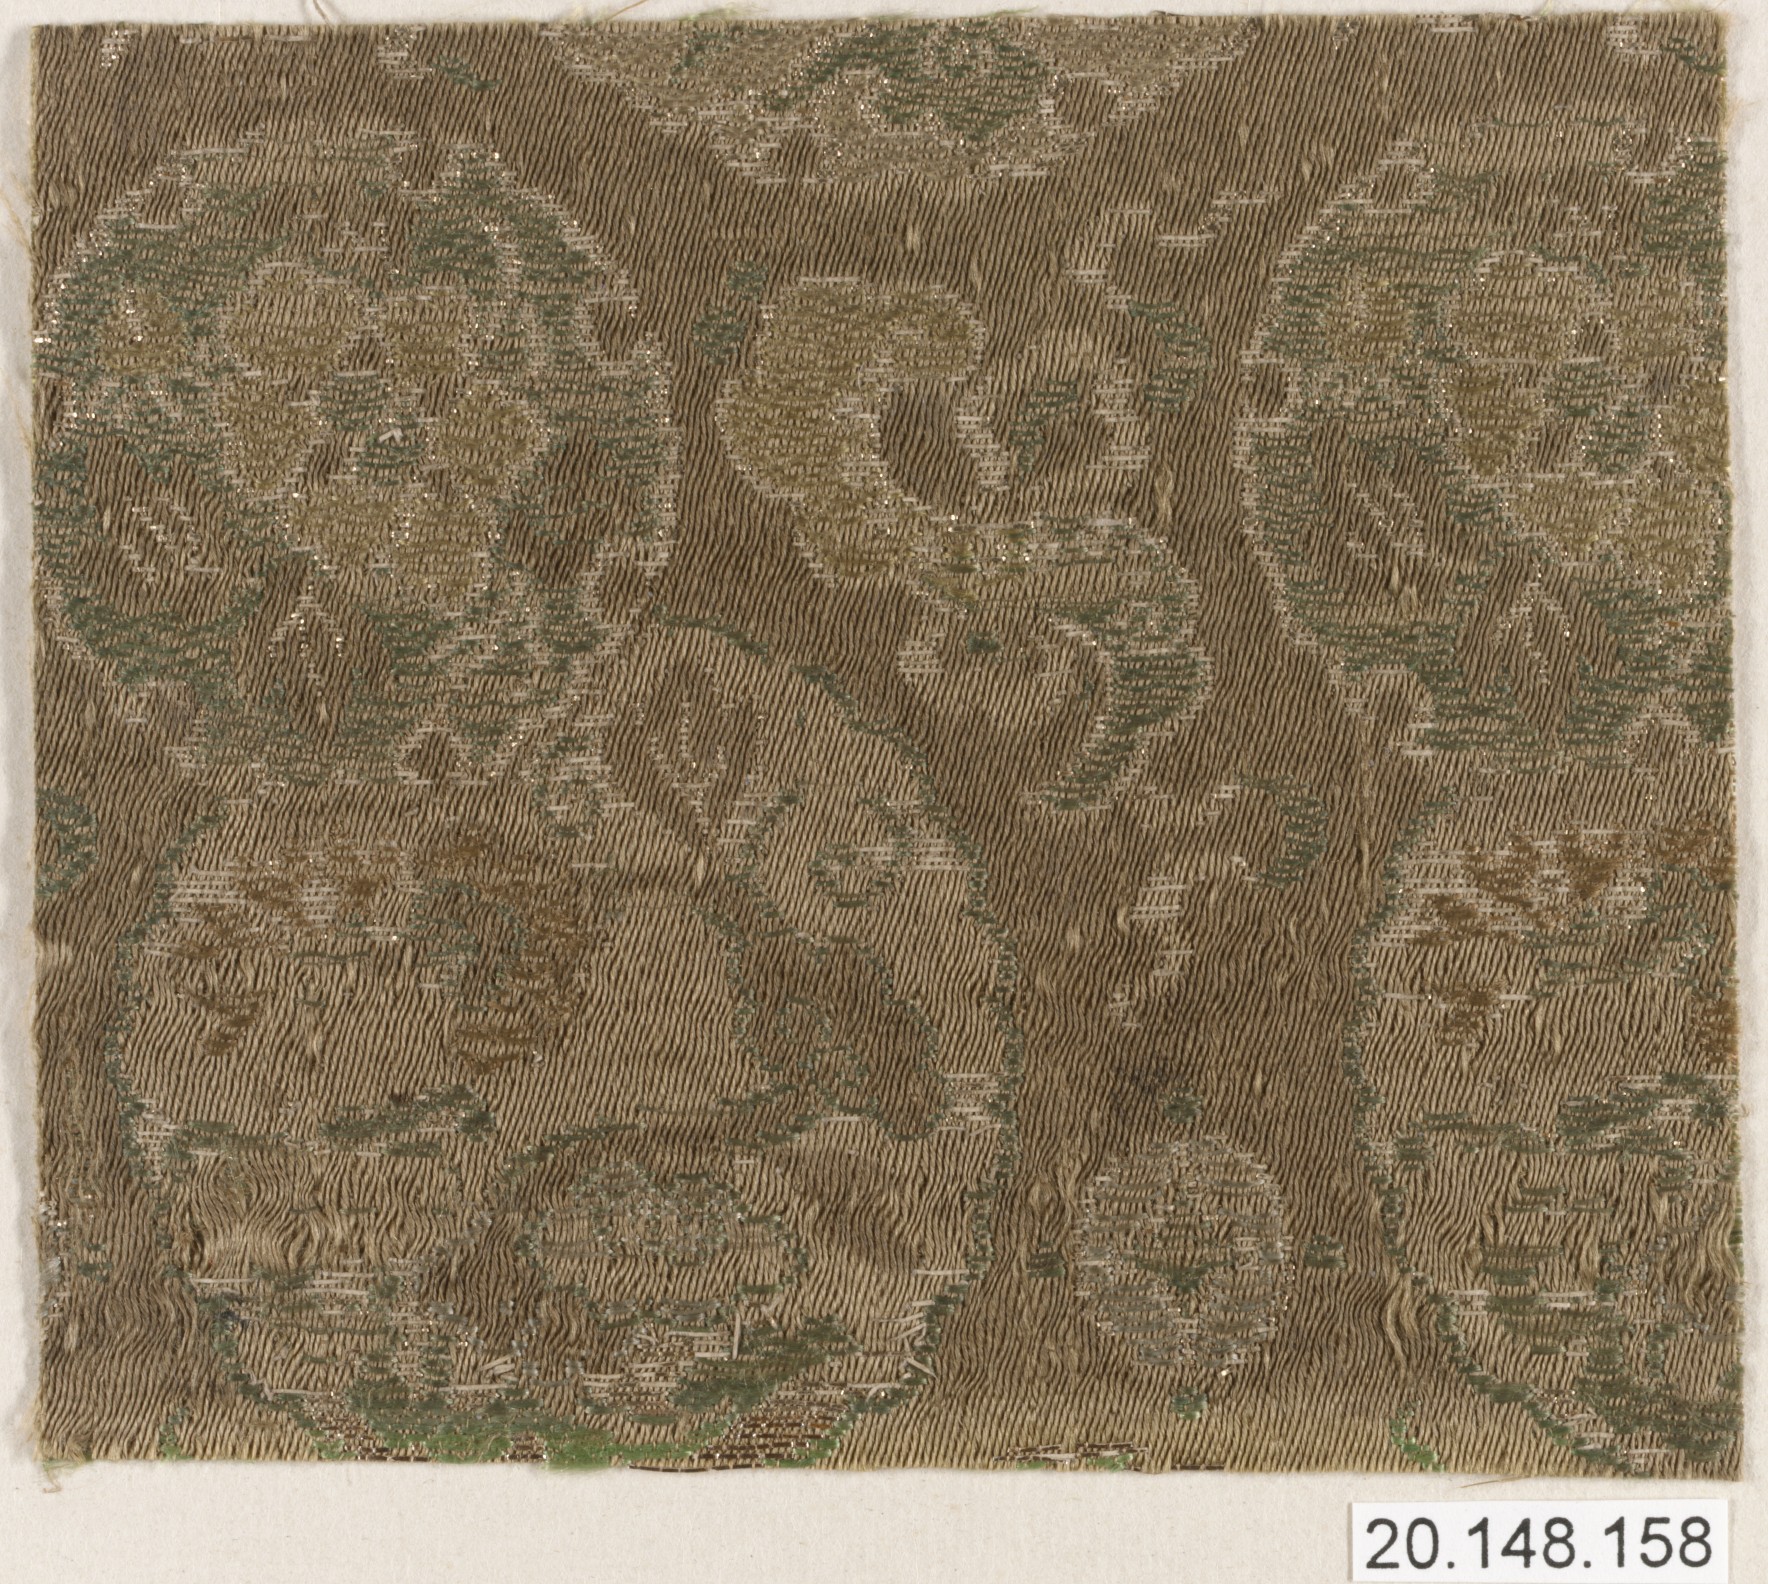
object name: piece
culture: japanese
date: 1601-1700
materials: silk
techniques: compound weave